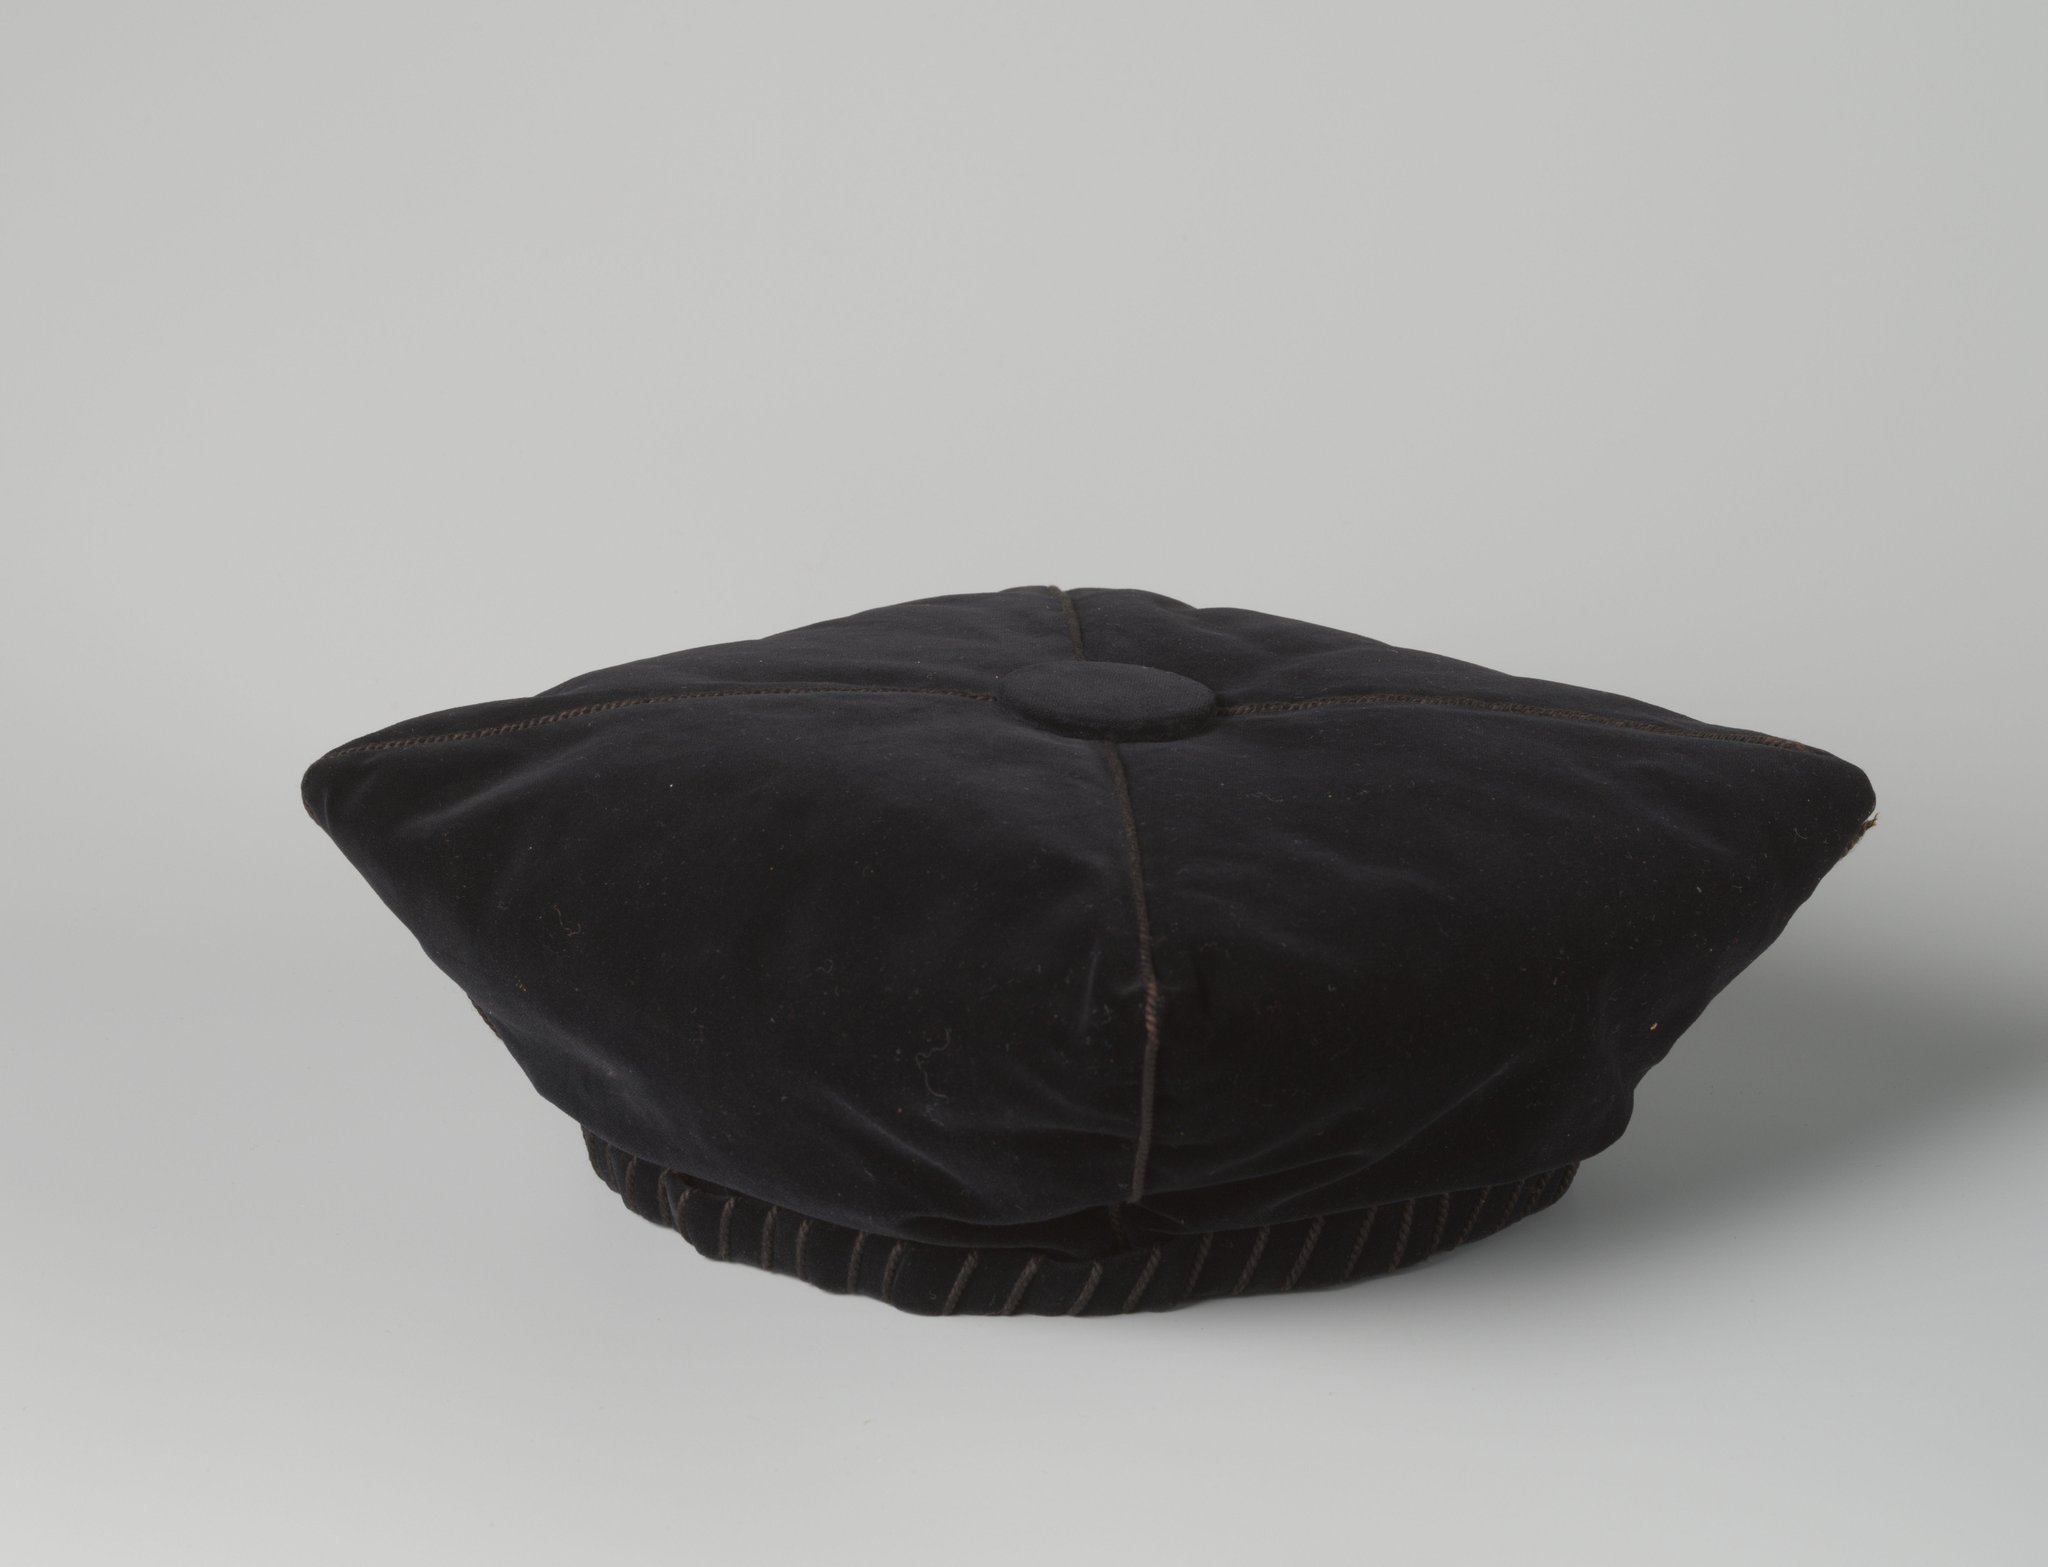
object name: menswear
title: Baret van zwart fluweel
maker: gerrit jan rhebergen (jan)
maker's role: print maker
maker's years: 1915-2002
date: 1946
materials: leather, silk, velvet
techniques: satin binding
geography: netherlands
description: Baret van zwart fluweel, vierkant en samengesteld uit vier delen. Stofknoop midden boven. Afgezet met koord. Voering: bruin lederen band en zwarte satijn. Op etiket: "G.J. Rhebergen, Amsterdam, Prof. Haspels, Feb. 1946.